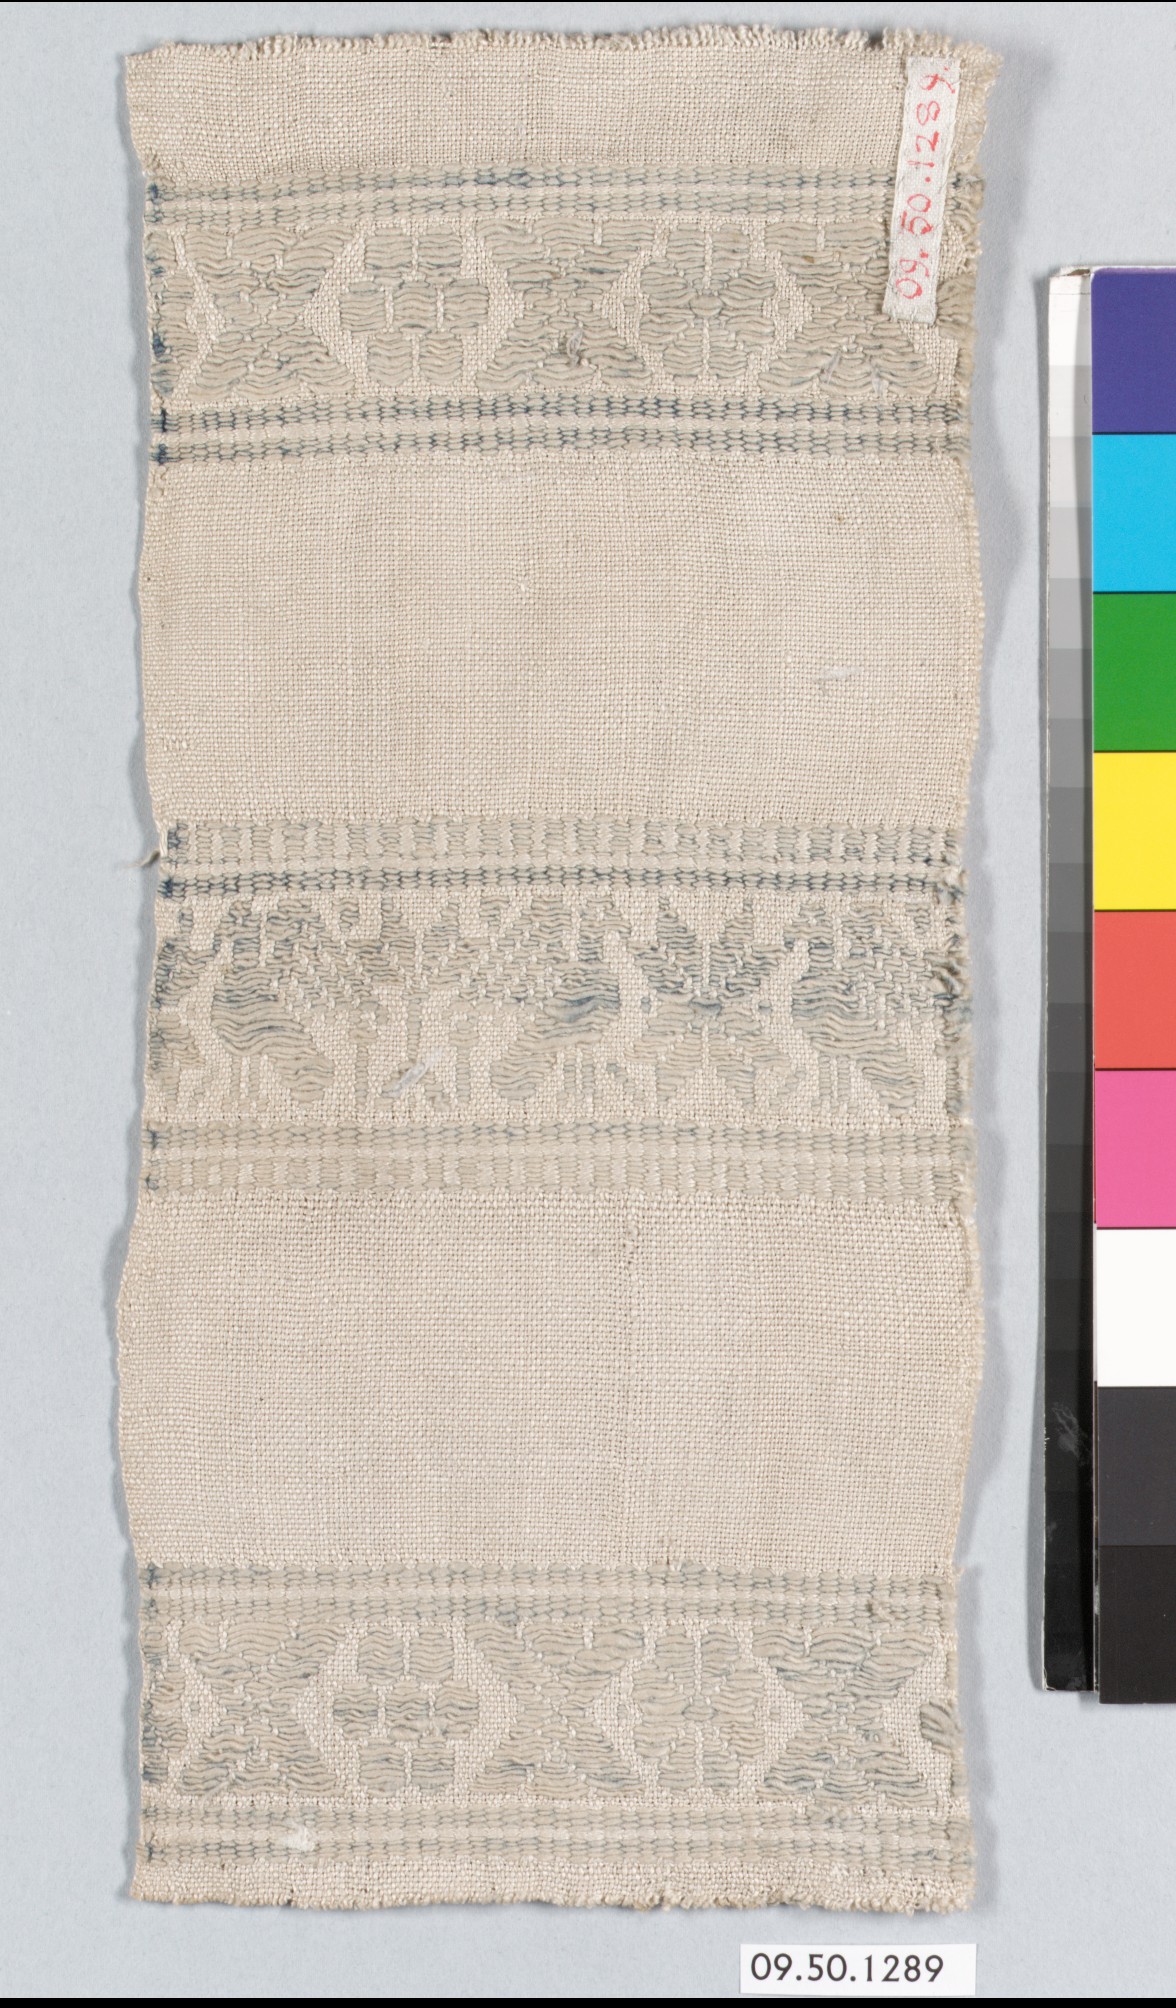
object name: piece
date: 1501-1700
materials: cotton, linen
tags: birds